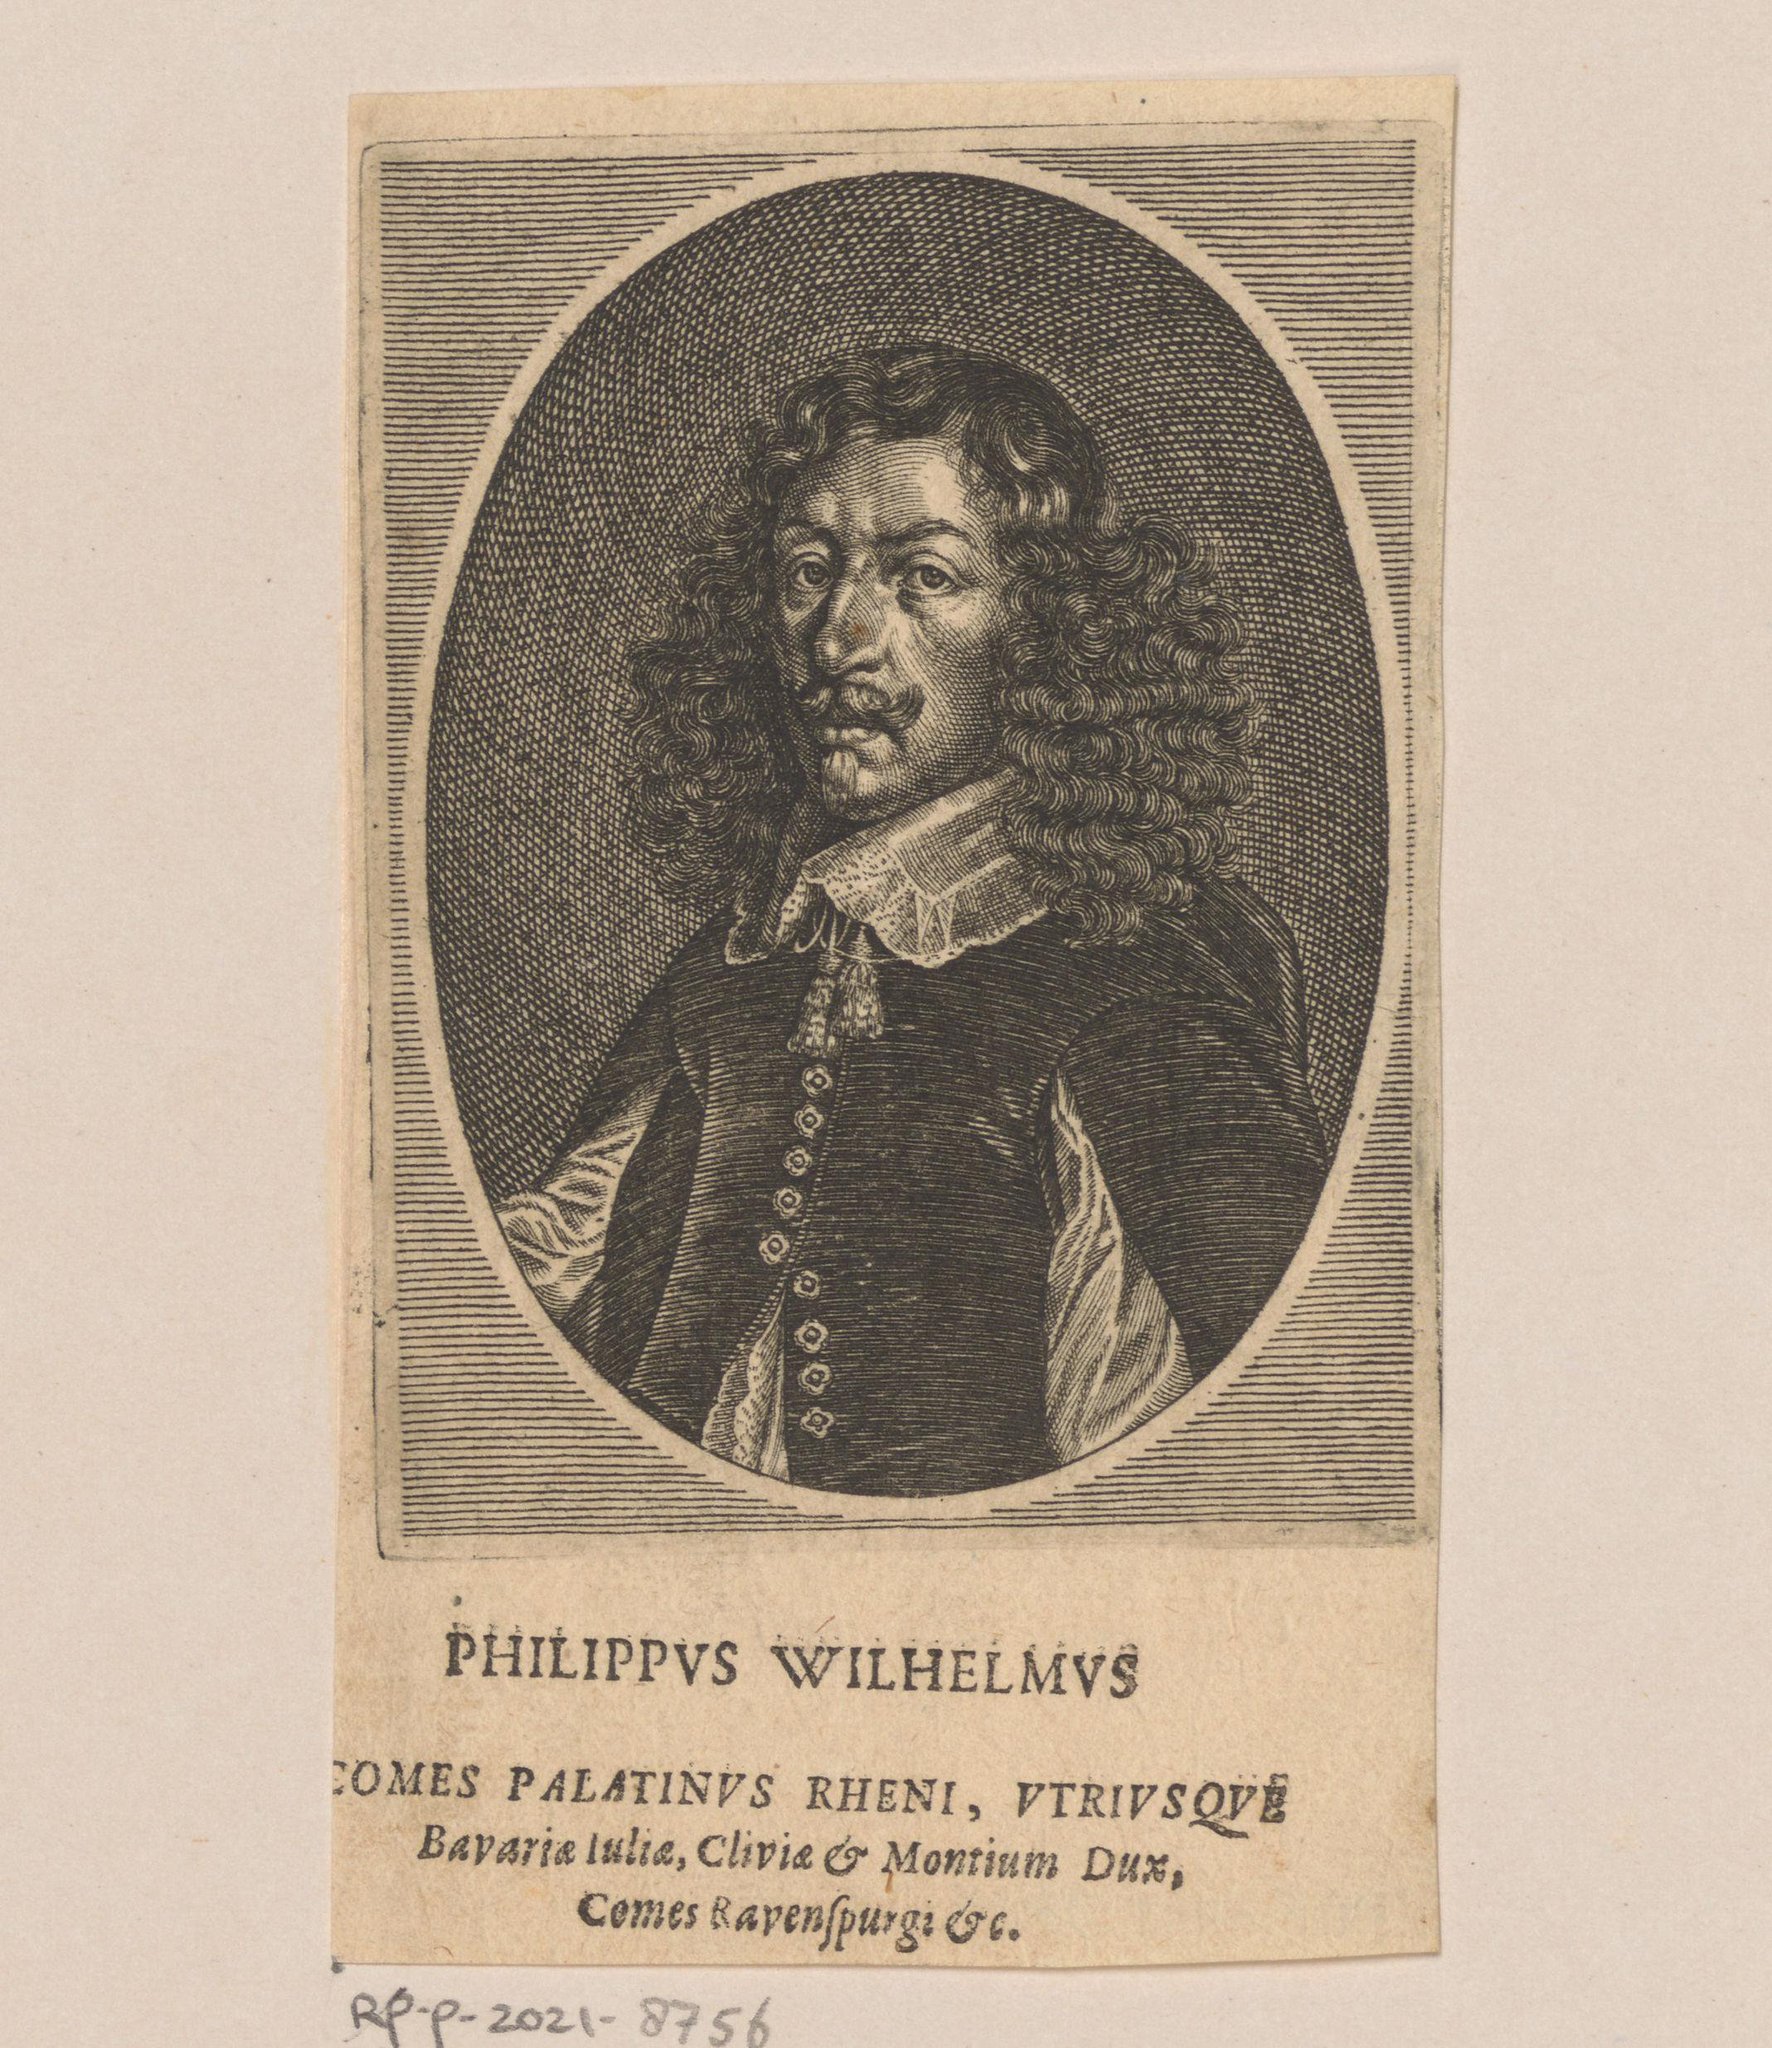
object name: print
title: Portret van Filips Willem van de Palts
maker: Anonymous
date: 1657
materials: paper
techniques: engraving, letterpress printing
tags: vienna, adult man, historical persons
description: Prent waarschijnlijk uit: Thülden, Christian Adolph. Historiae nostri temporis ab Anno Christi 1652 usque ad 1657. Keulen: Johannes Antonius Kinchius, 1657.